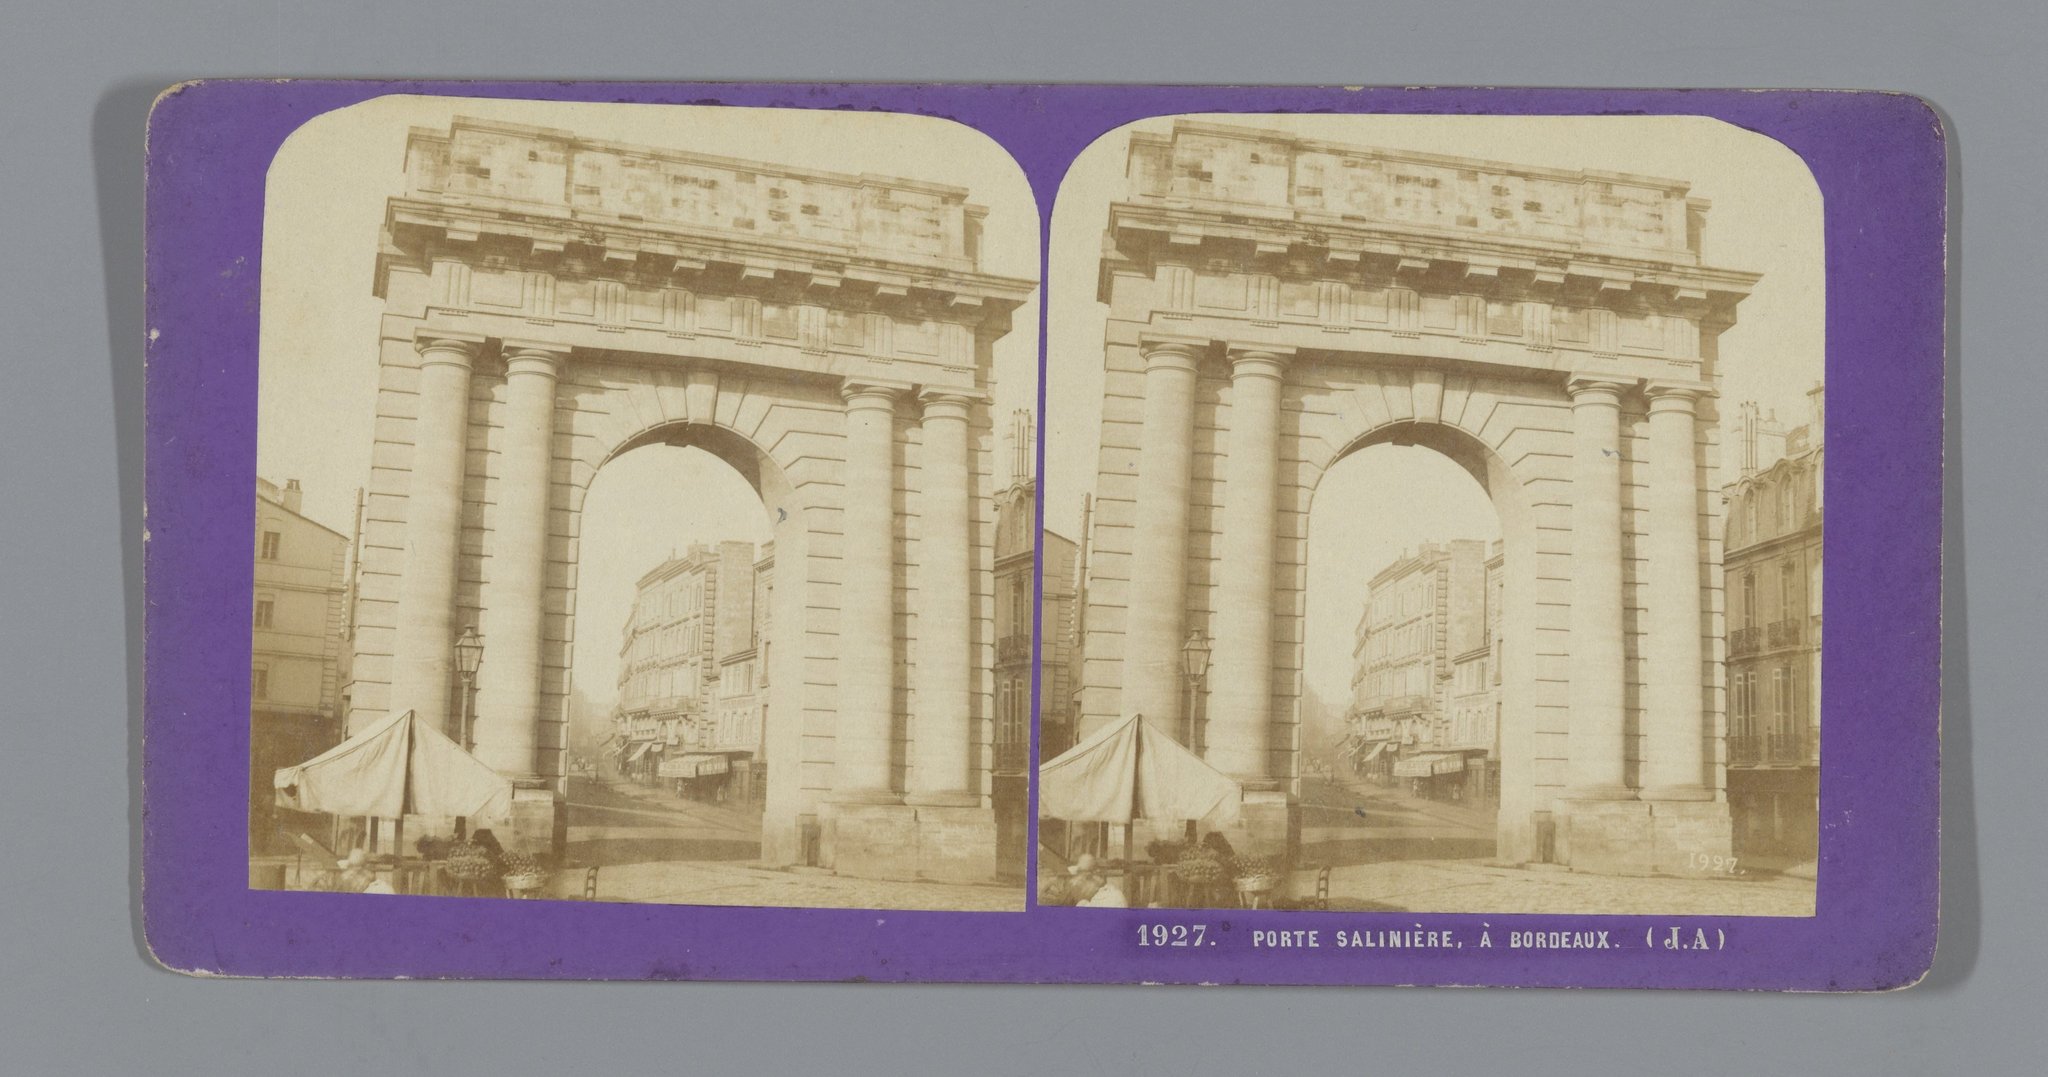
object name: stereograph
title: Porte Salinière, à Bordeaux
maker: jean andrieu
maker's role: fotograaf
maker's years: 1816-1872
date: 1862-1876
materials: cardboard, photographic support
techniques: albumen print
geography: bordeaux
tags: triumphal arch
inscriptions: number: ‘1927.’